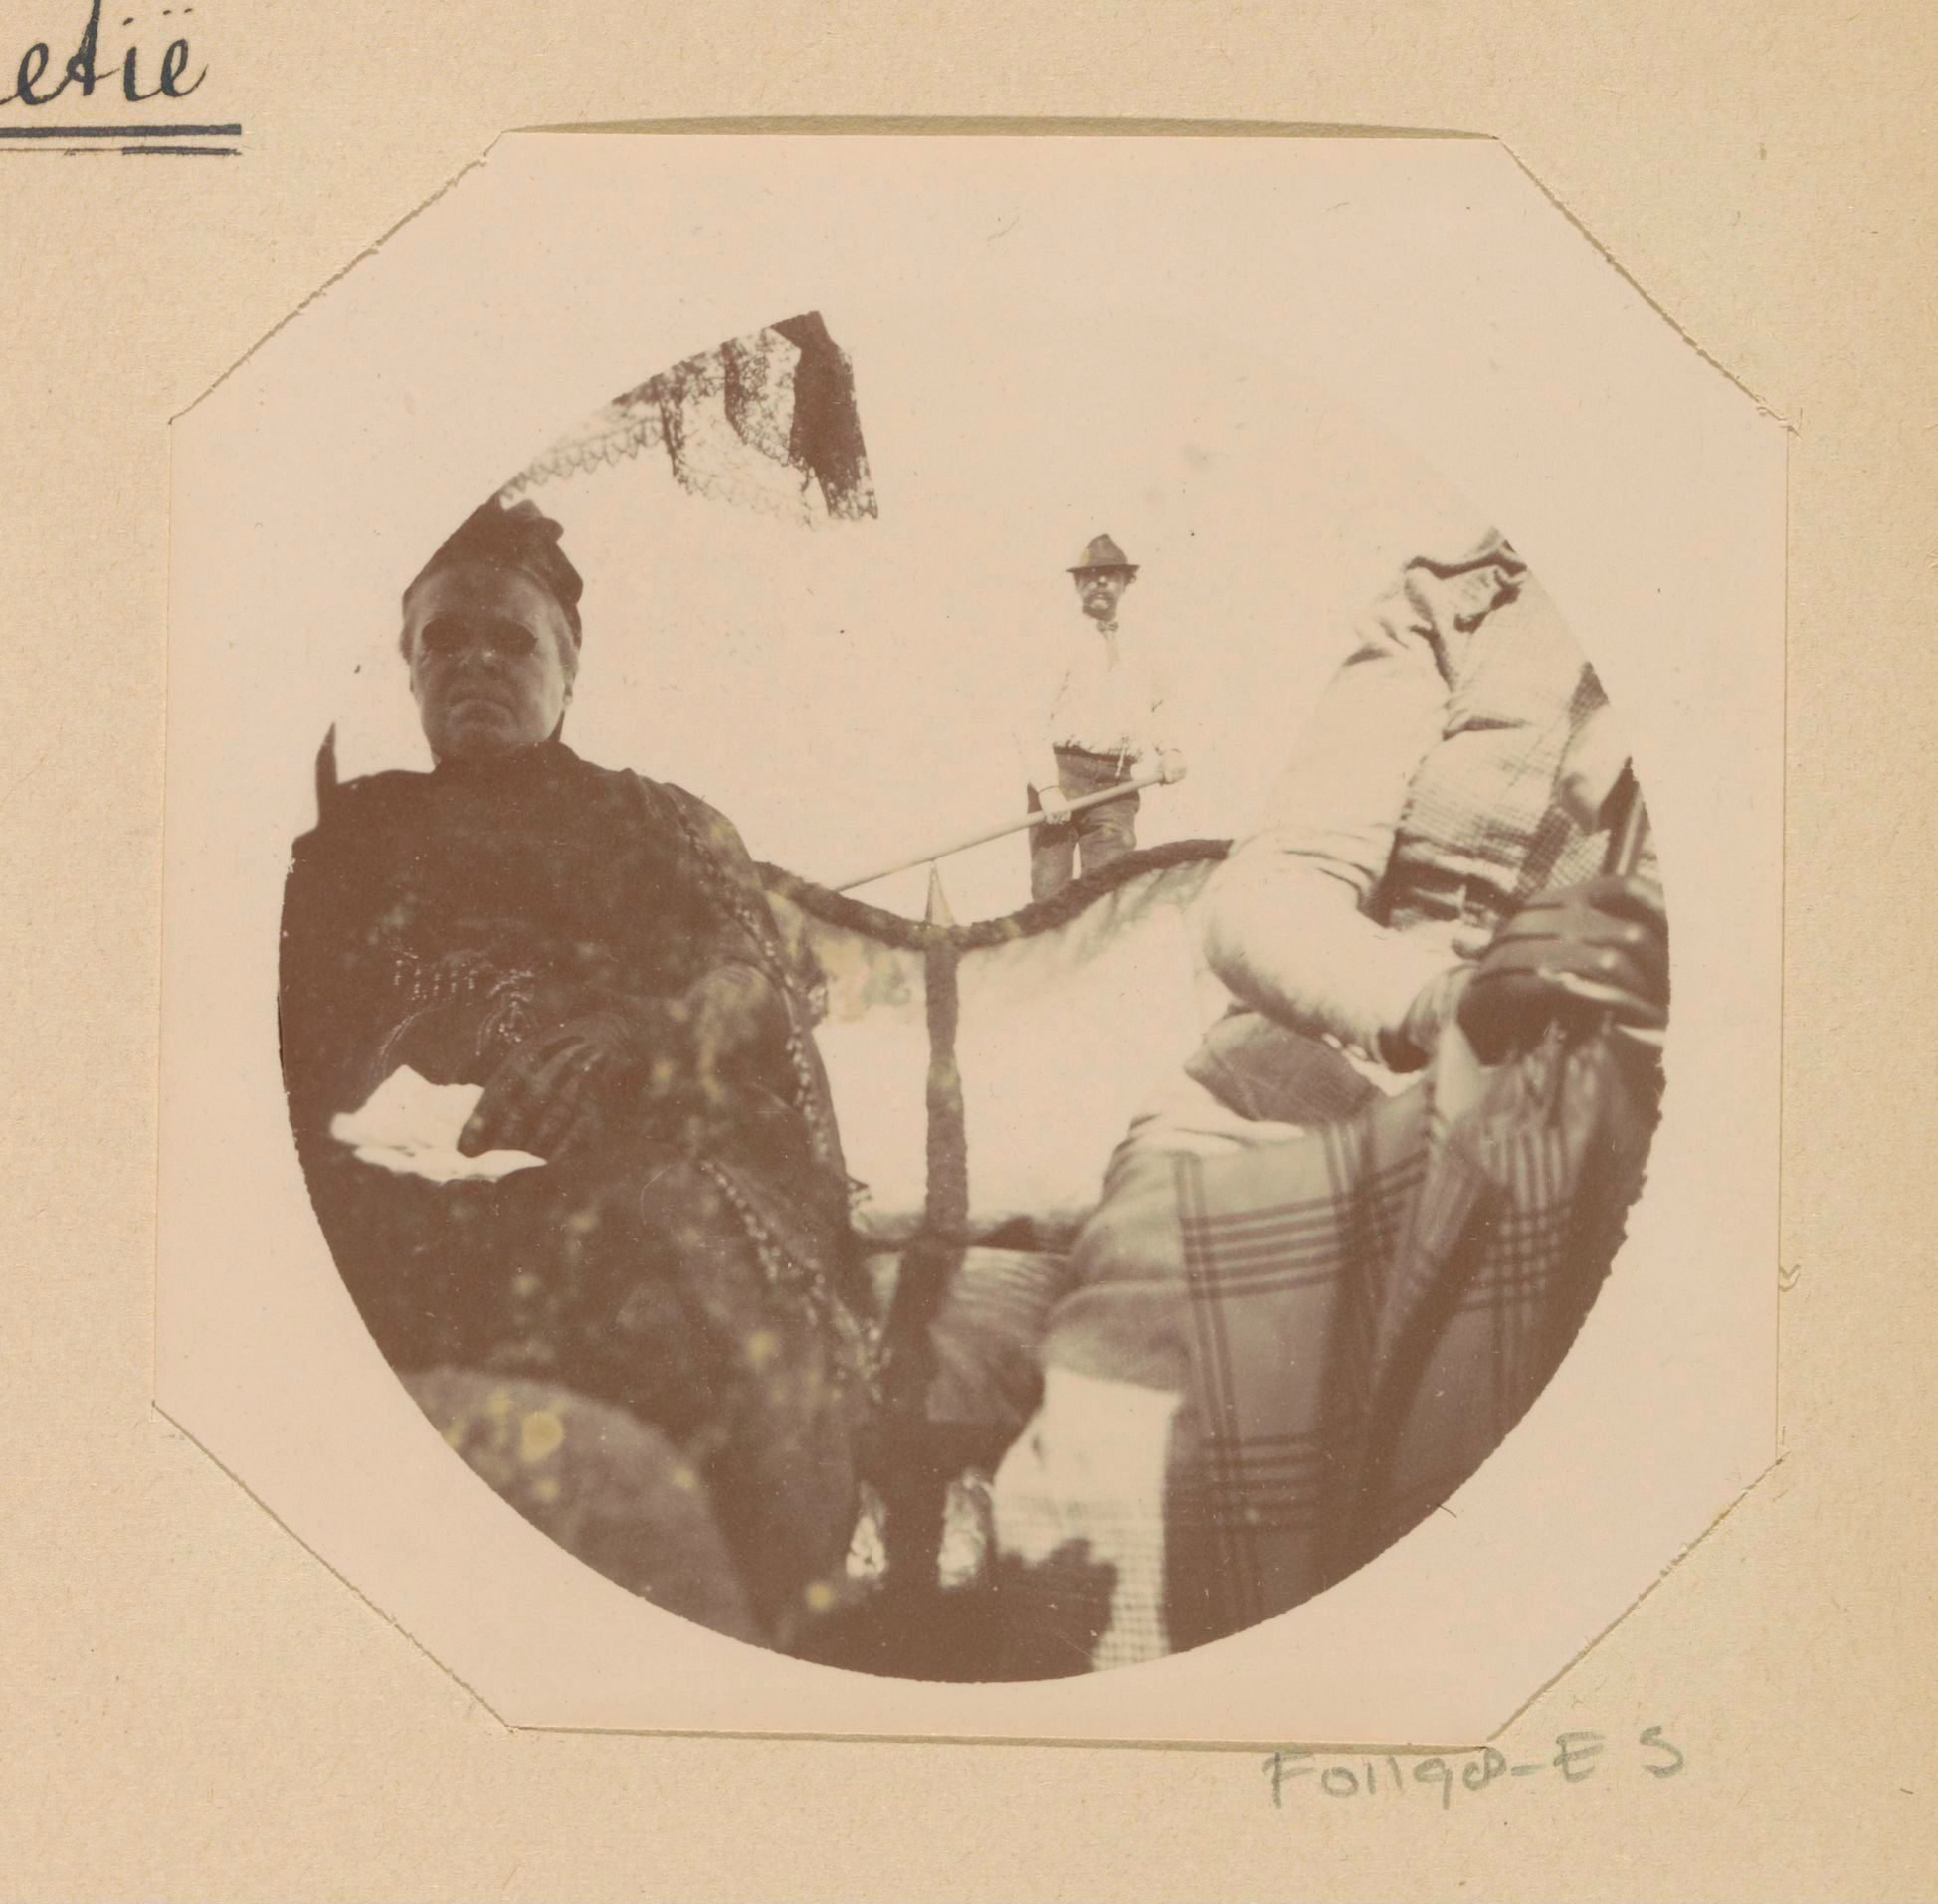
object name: photograph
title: Portret van Lucia Wilhelmina Piek-Jolles naast een onbekende vrouw in een gondel in Venetië, achterin de gondelier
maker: johanna margaretha piek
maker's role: fotograaf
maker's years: 1870-1947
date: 1889-1893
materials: paper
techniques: gelatin silver print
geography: venice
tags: amsterdam, historical persons, gondola, venice